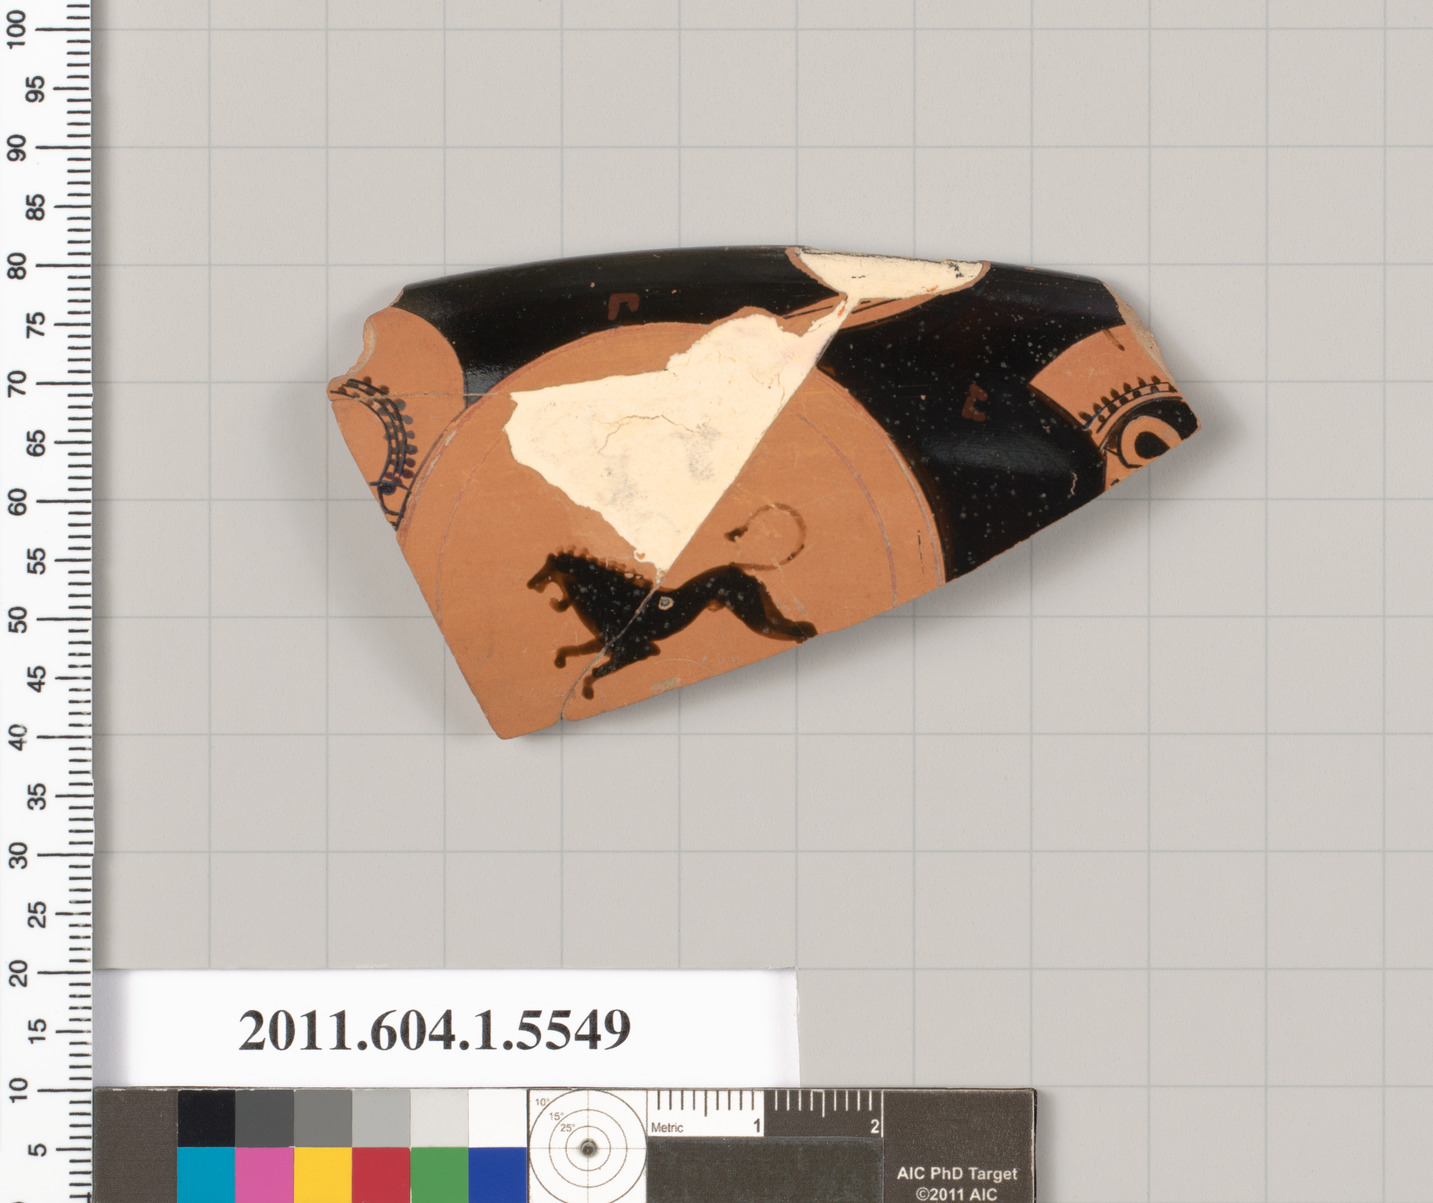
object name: kylix fragment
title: Terracotta rim fragment of a kylix (drinking cup)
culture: greek, attic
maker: epeleios painter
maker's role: artist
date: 510-490 BCE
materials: terracotta